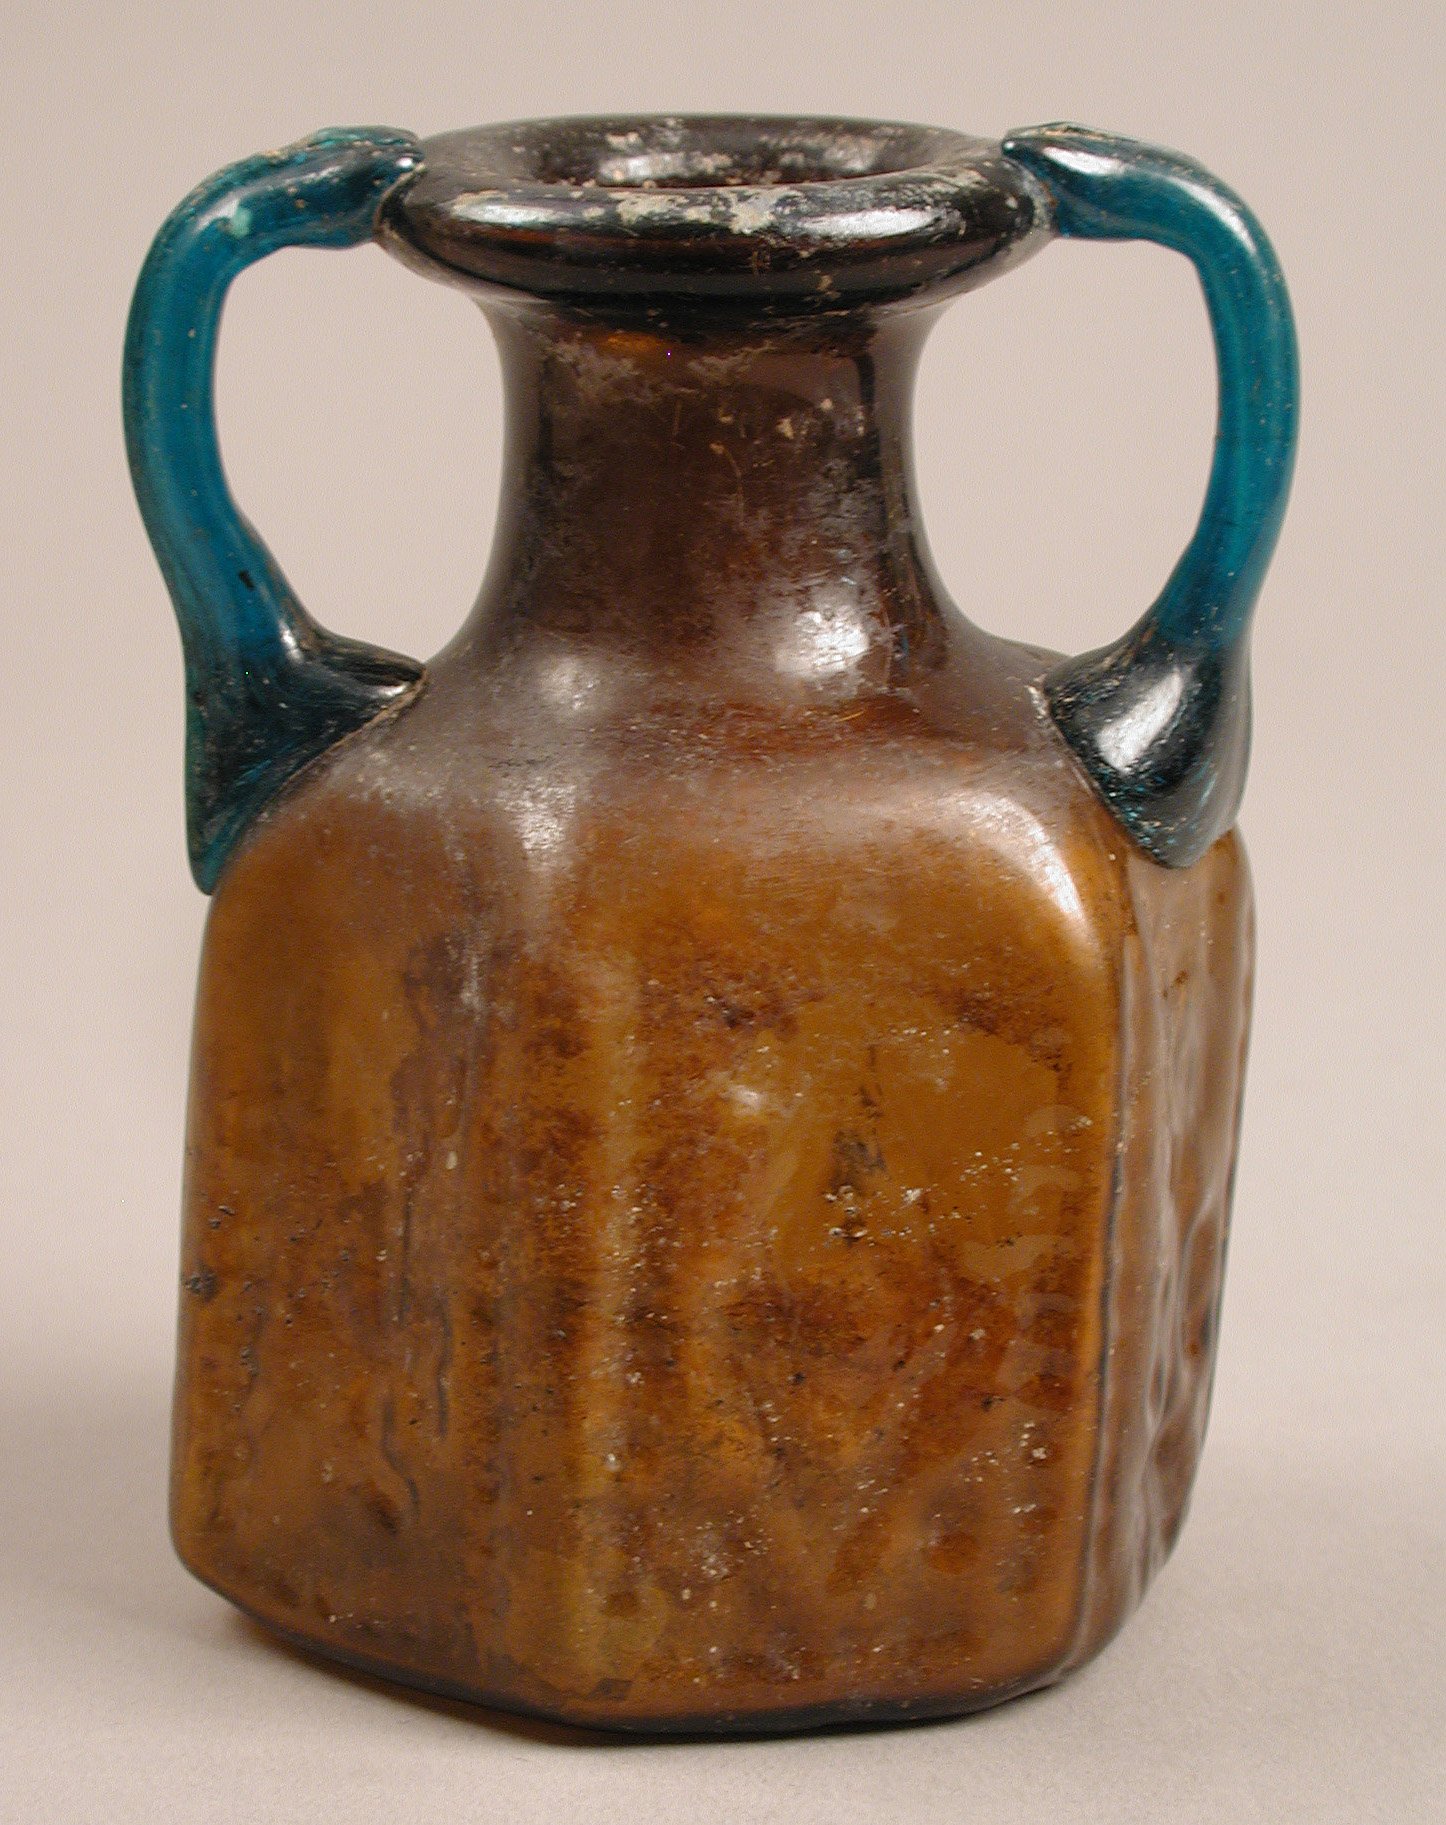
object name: jug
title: Hexagonal Jug with Handles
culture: byzantine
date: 501-666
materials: glass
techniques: molding